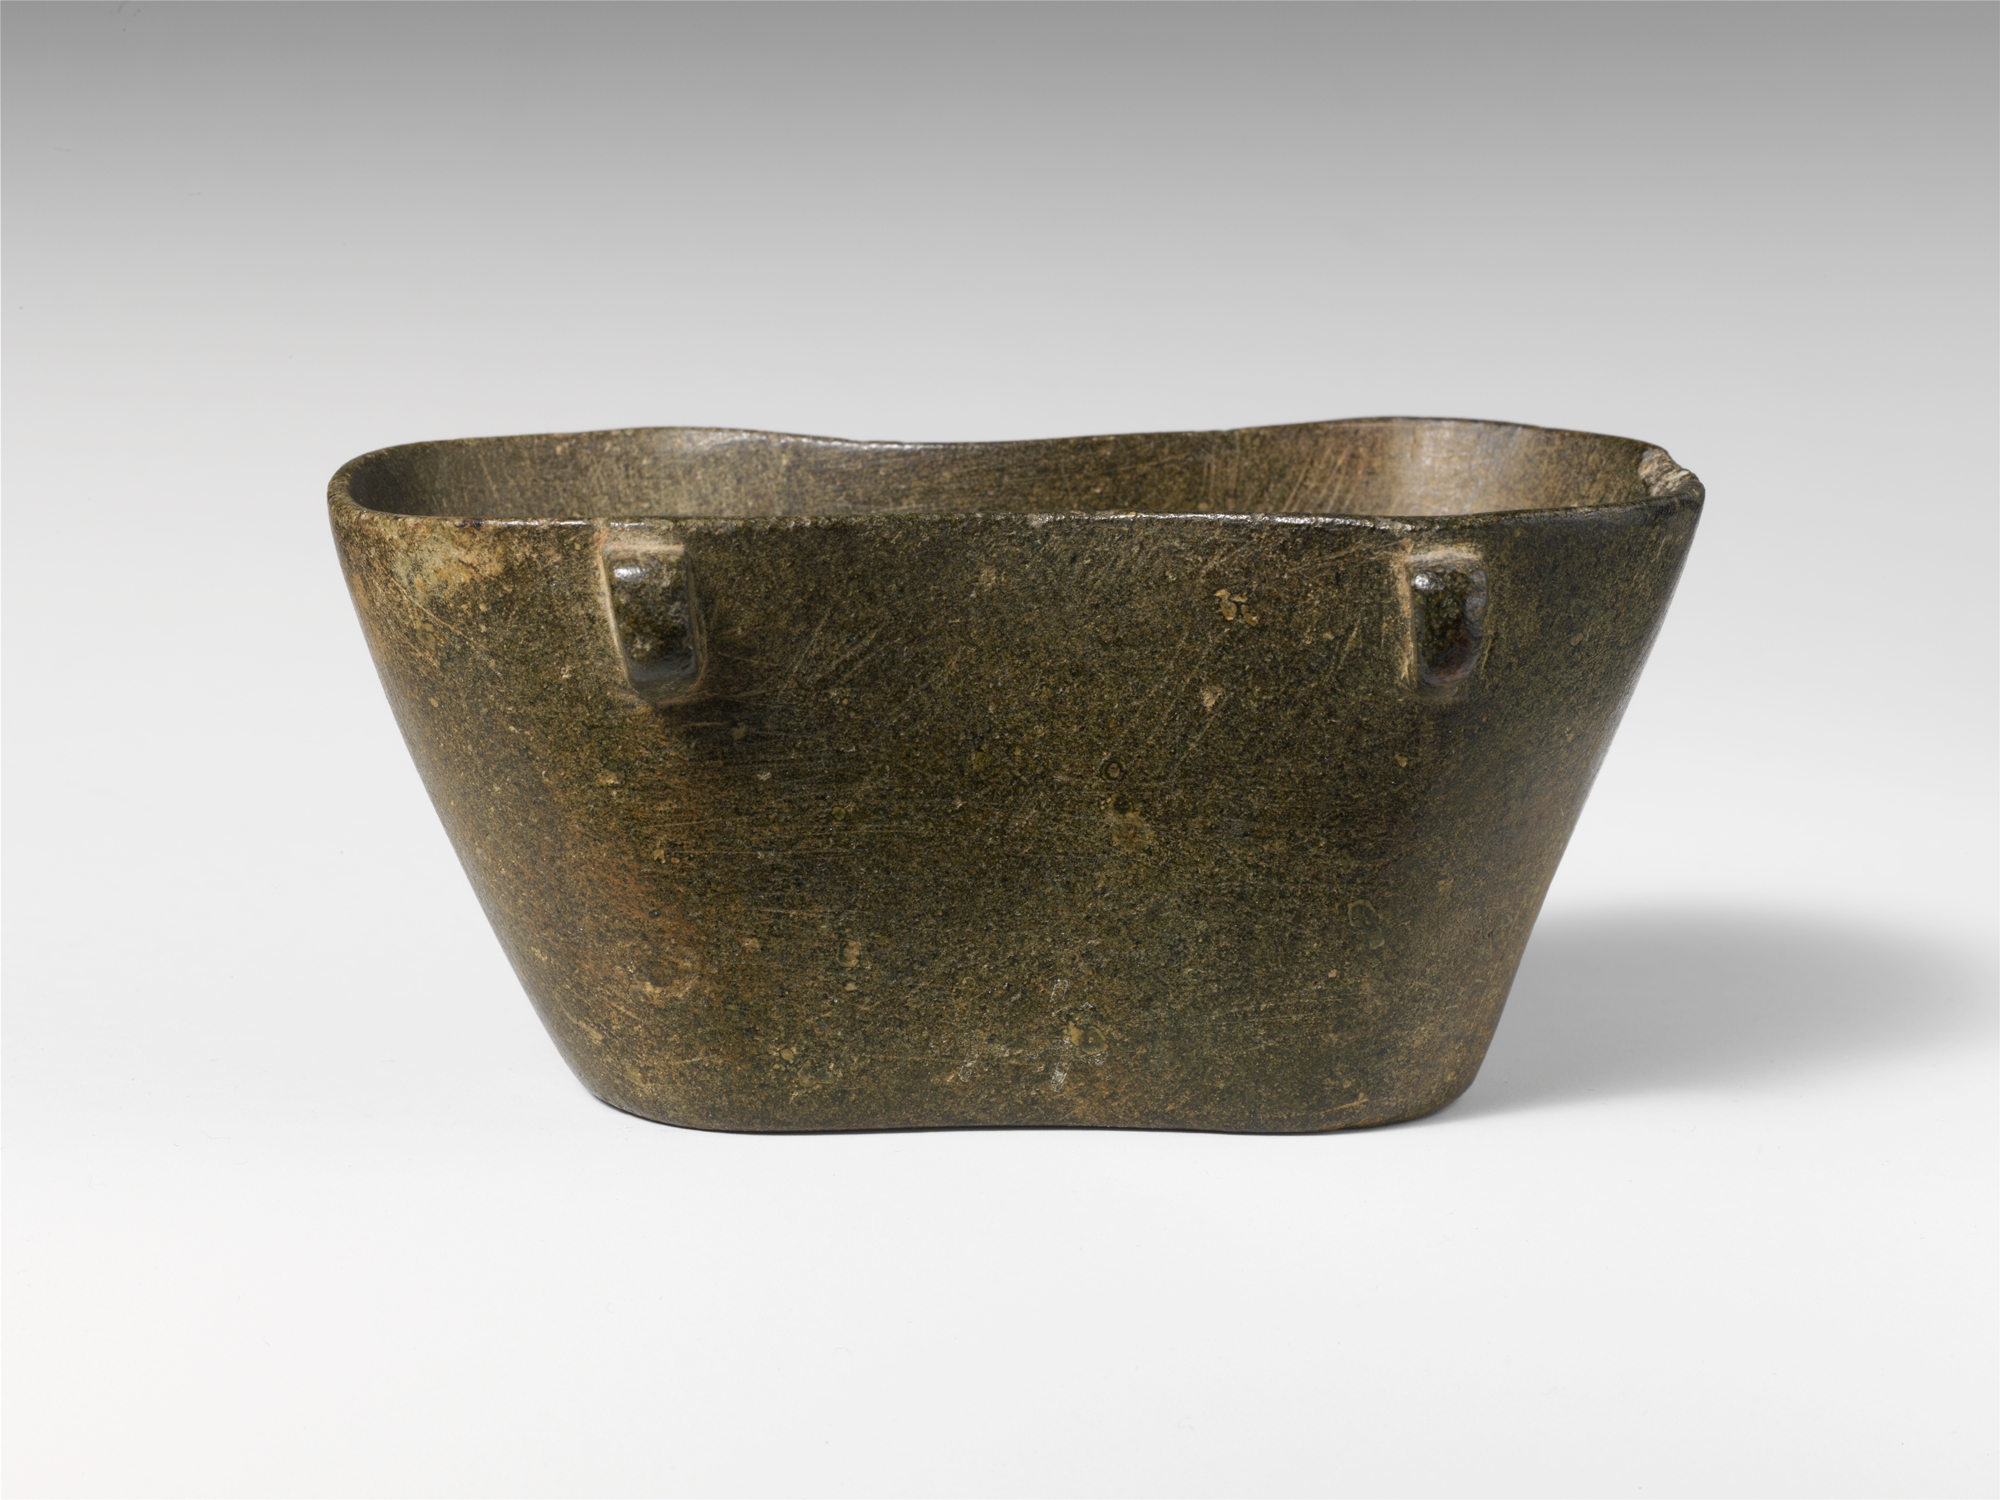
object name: bathtub, miniature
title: Chlorite miniature bathtub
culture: cypriot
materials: mineral